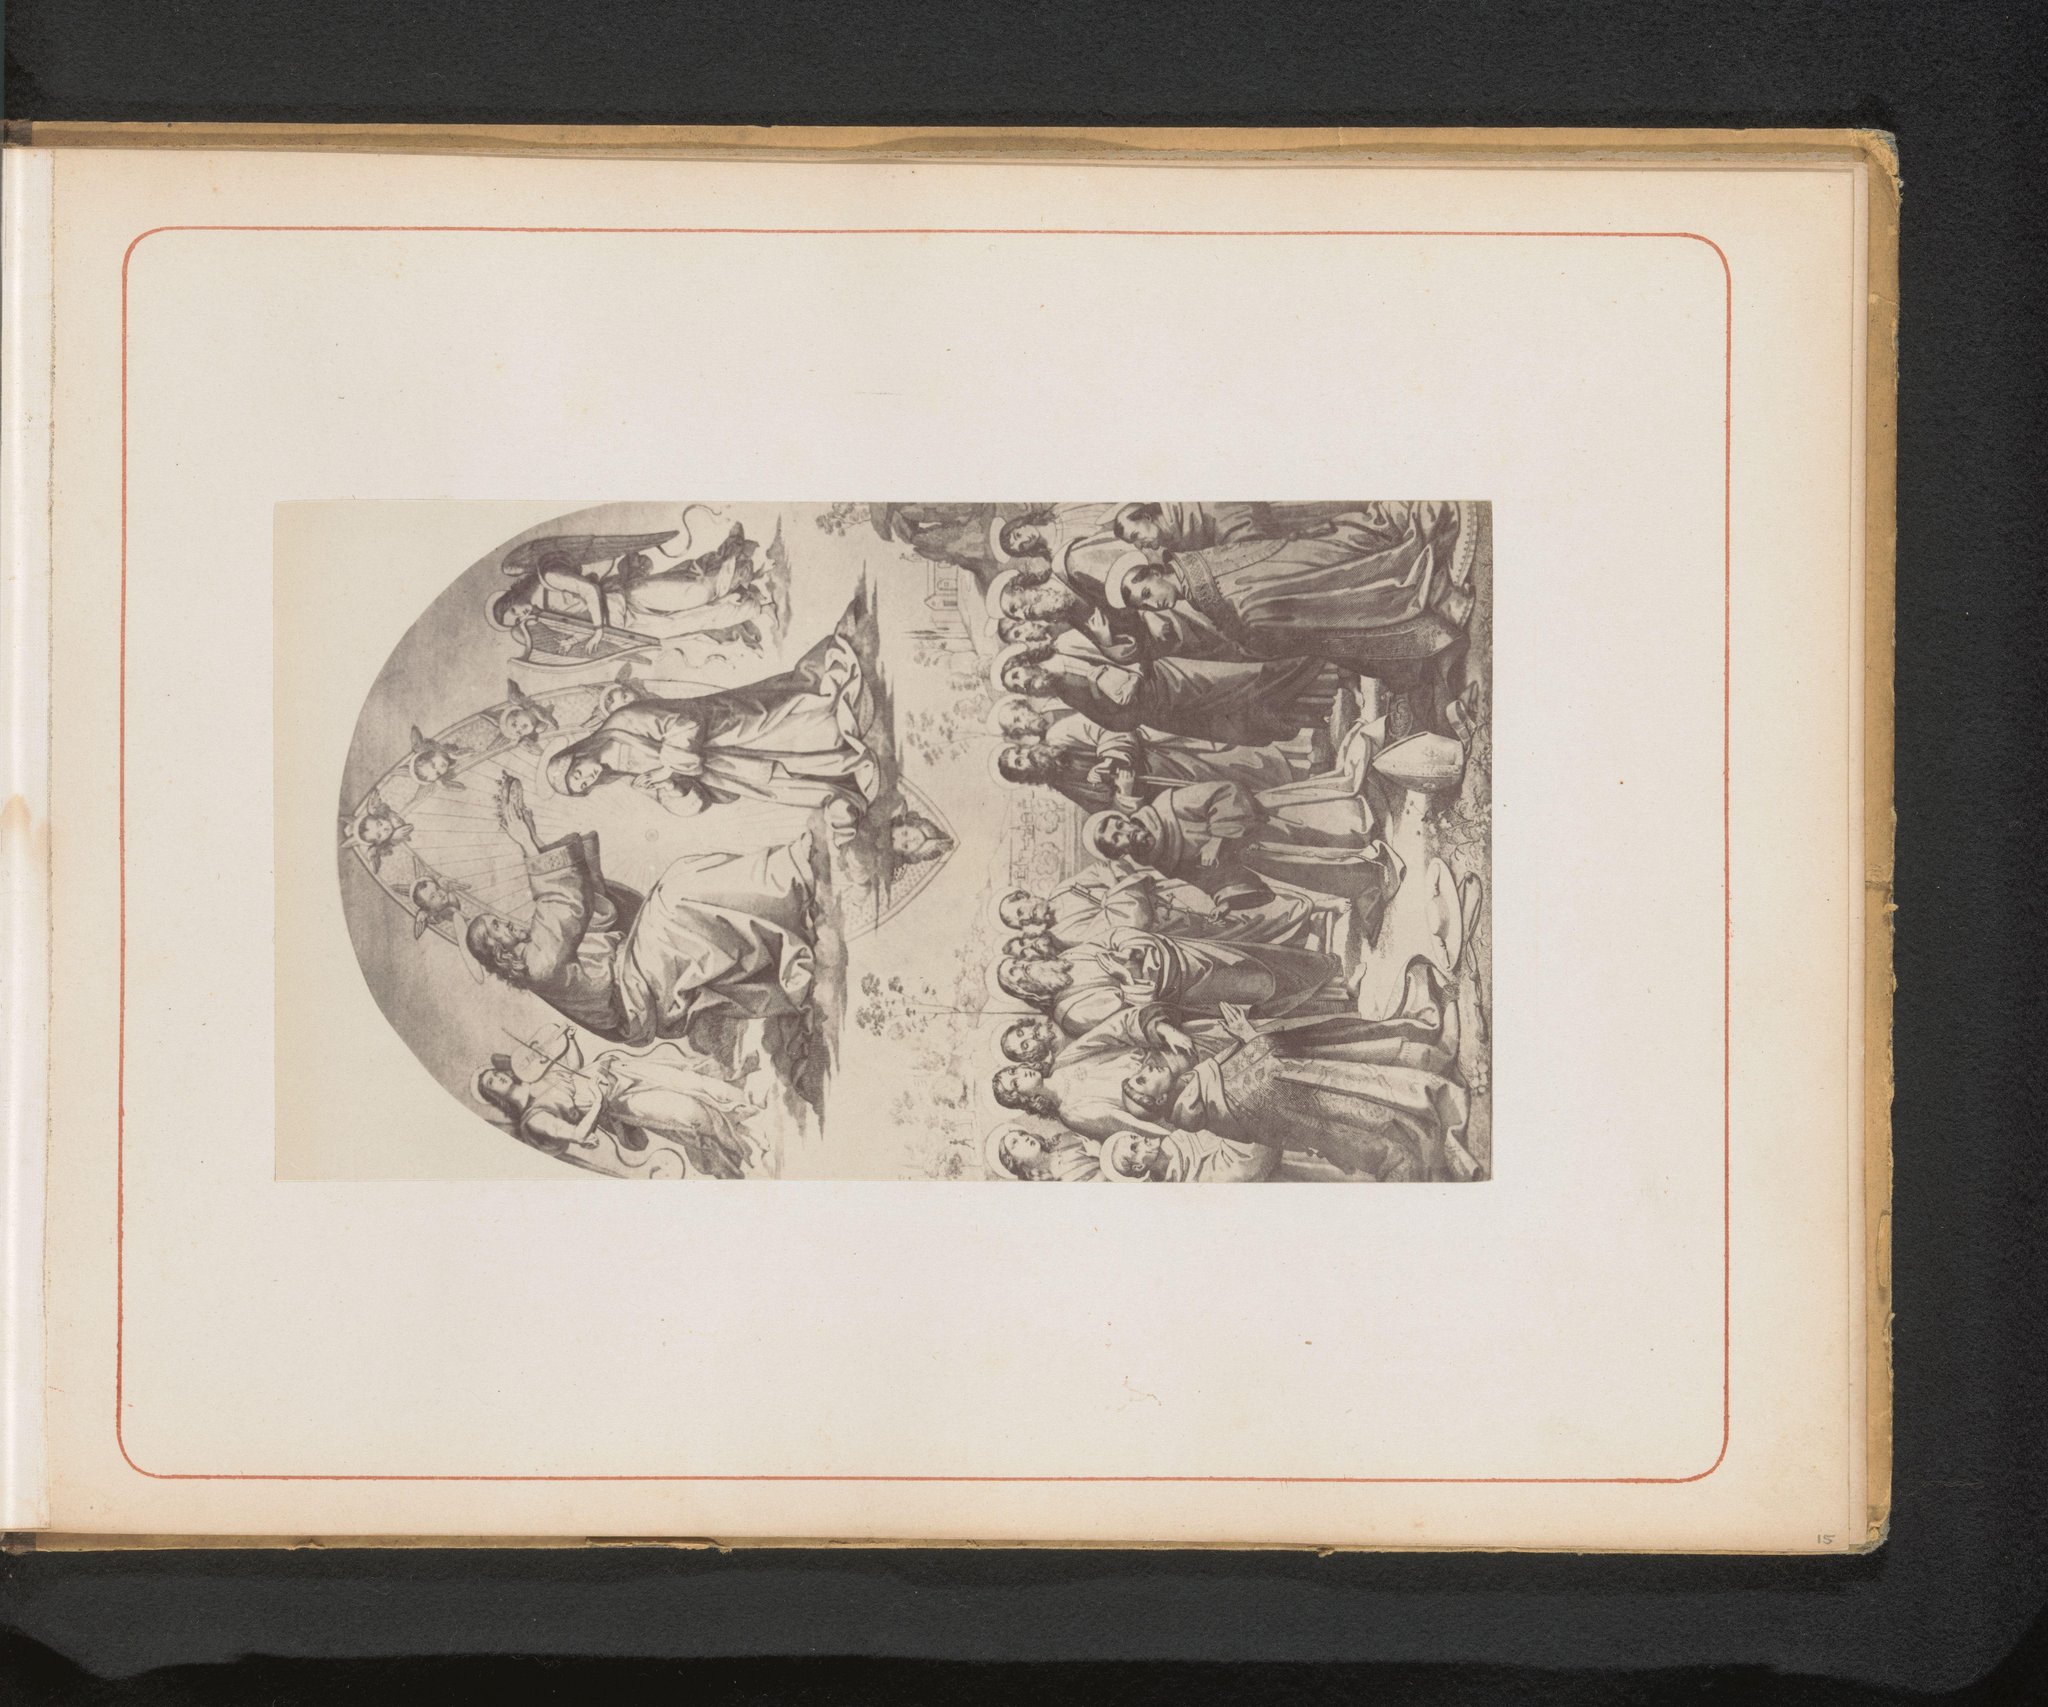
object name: page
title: Fotoreproductie van een gravure naar De kroning van Maria door Pinturicchio in het Vaticaan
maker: Anonymous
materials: photographic support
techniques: albumen print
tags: coronation of mary by christ